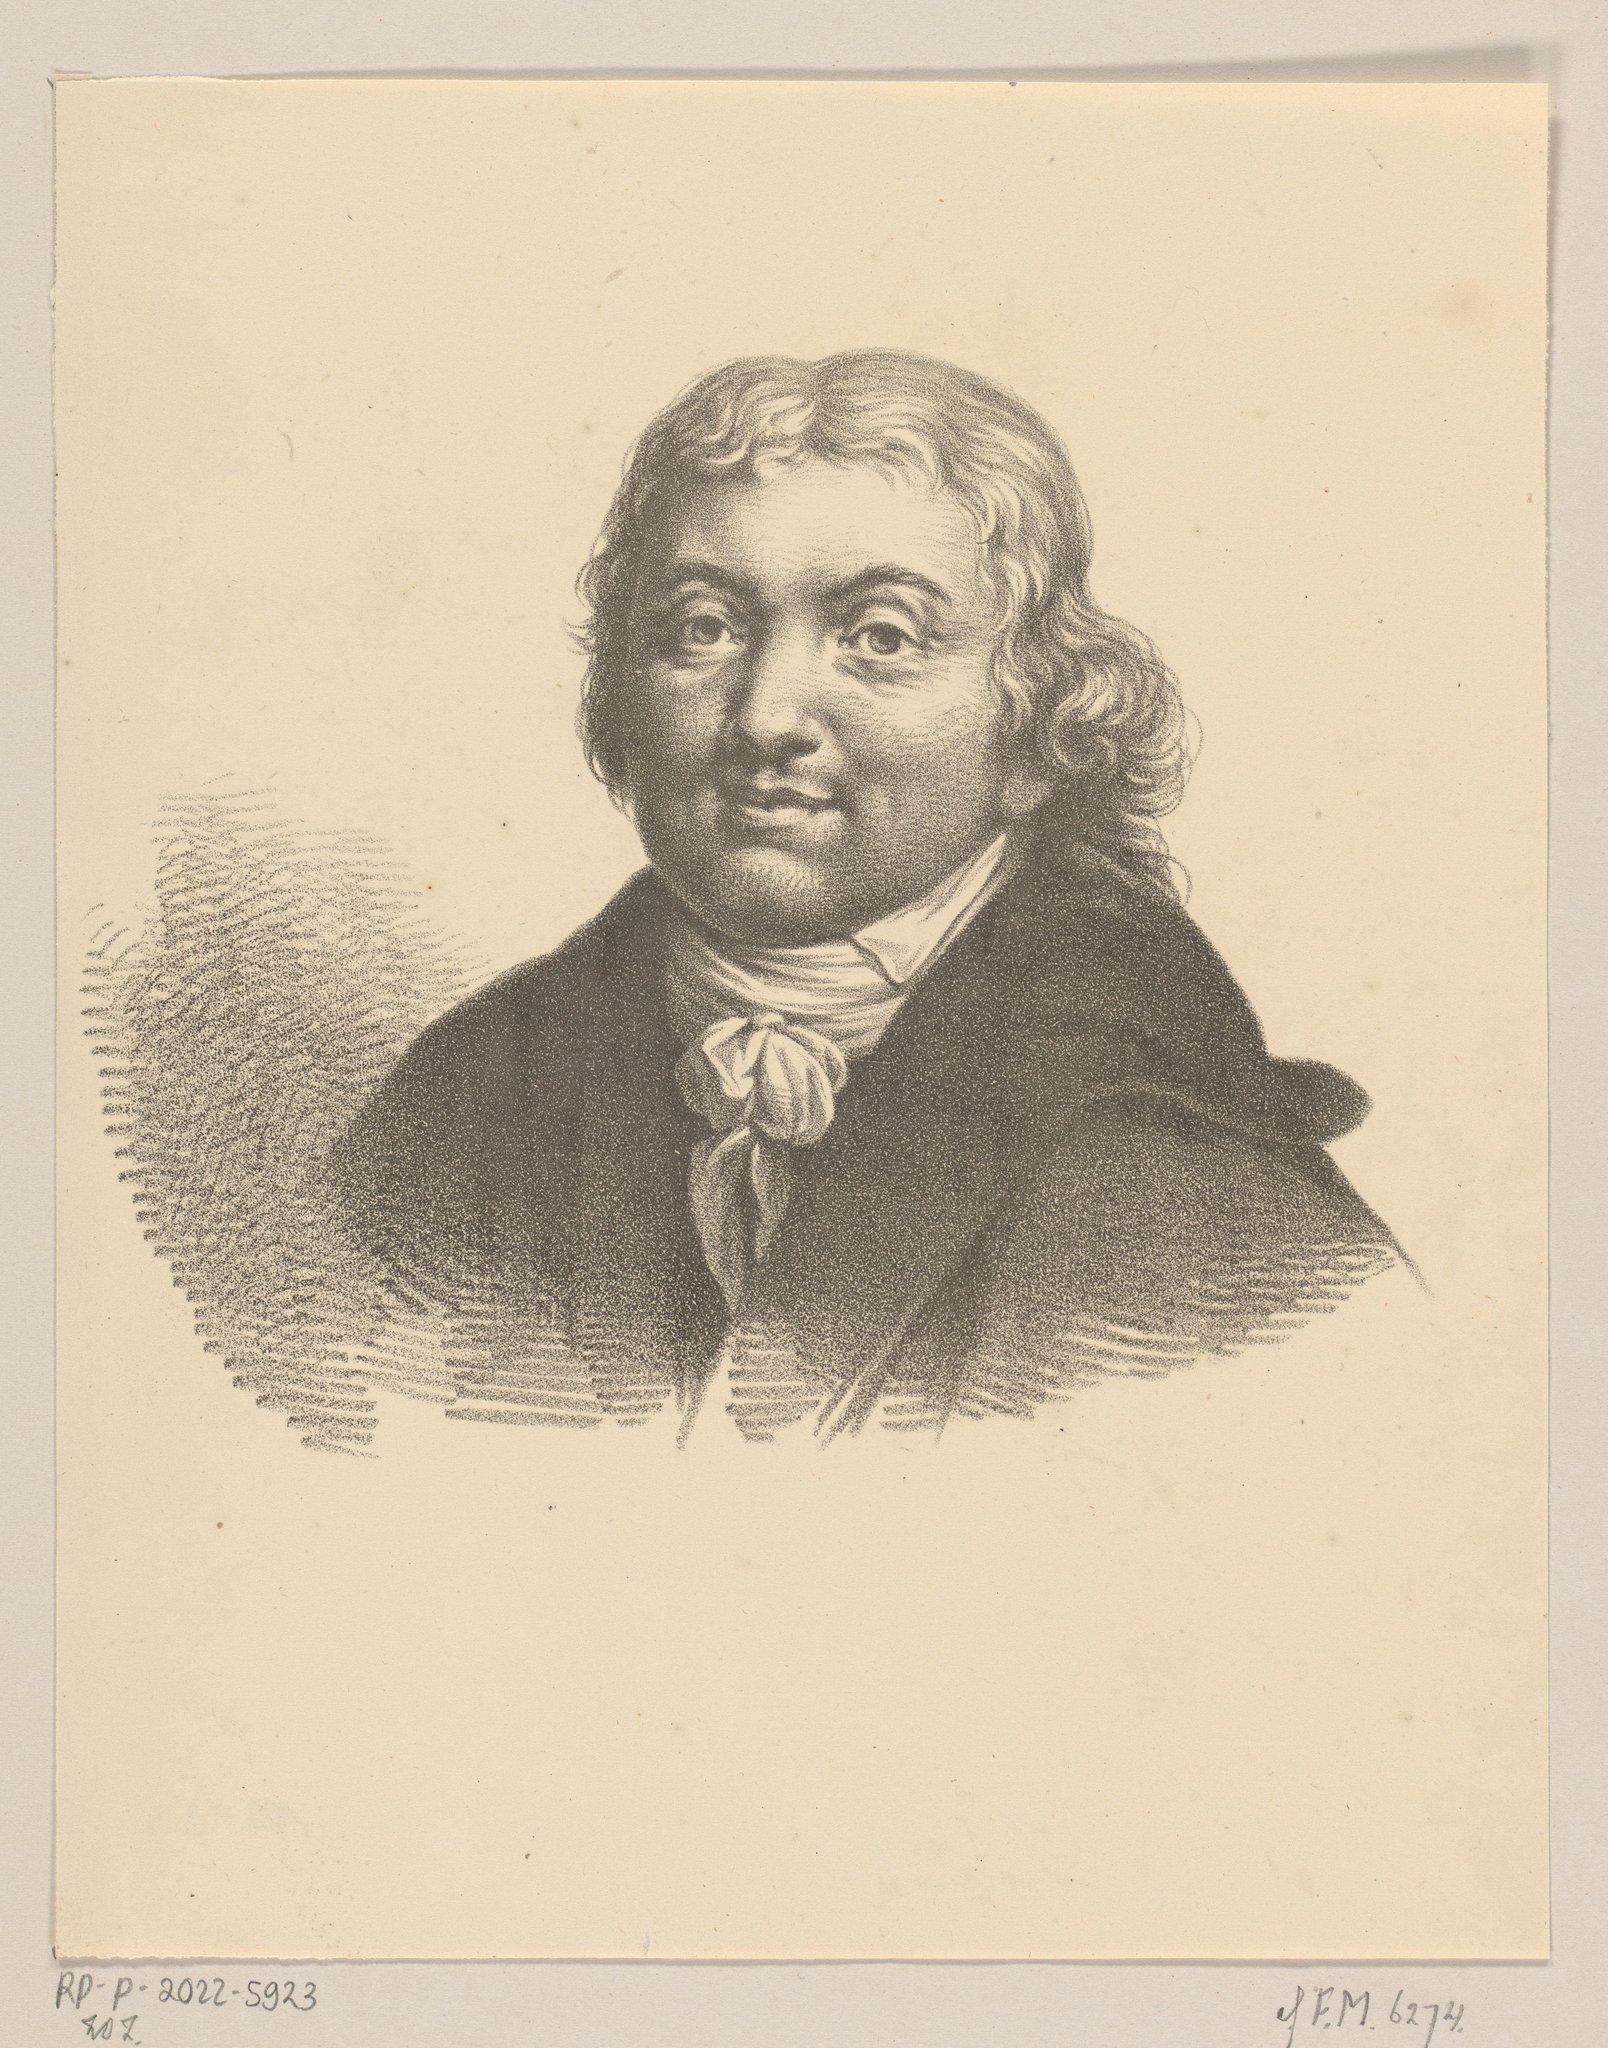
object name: print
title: Portret van Daniël Wyttenbach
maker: Anonymous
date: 1800-1850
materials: paper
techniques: lithograph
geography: netherlands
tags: historical persons, professor